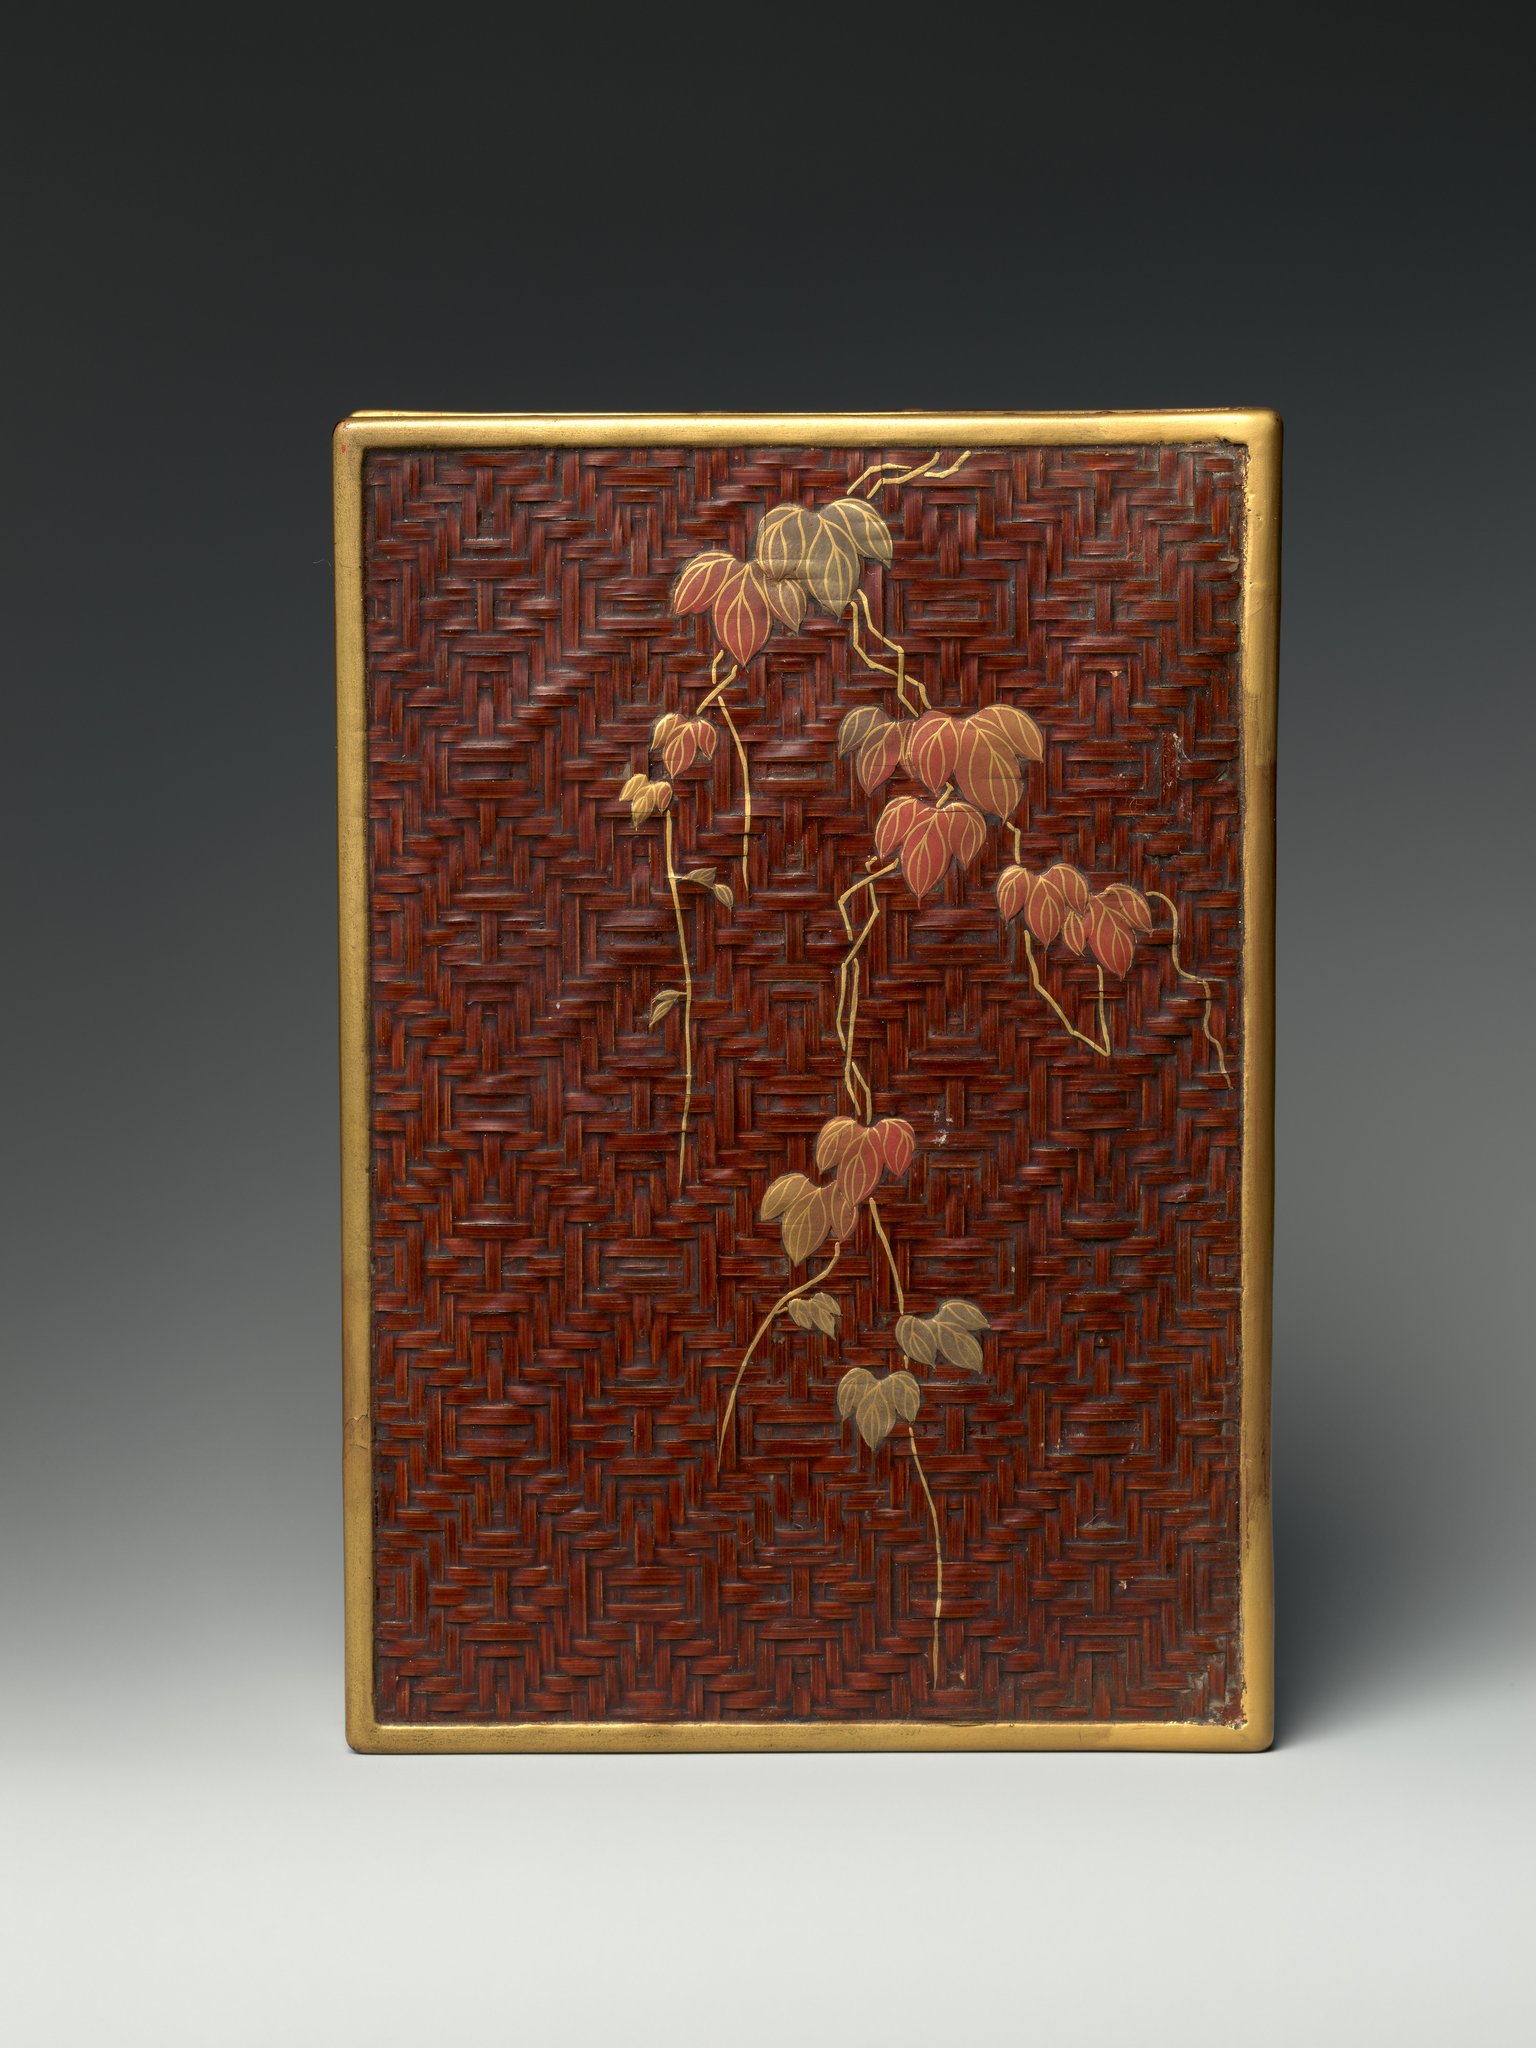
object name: box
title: Basketwork Box with Ivy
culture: japanese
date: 1834-1866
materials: bamboo, gold, lacquer, silver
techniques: hiramakie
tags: vines